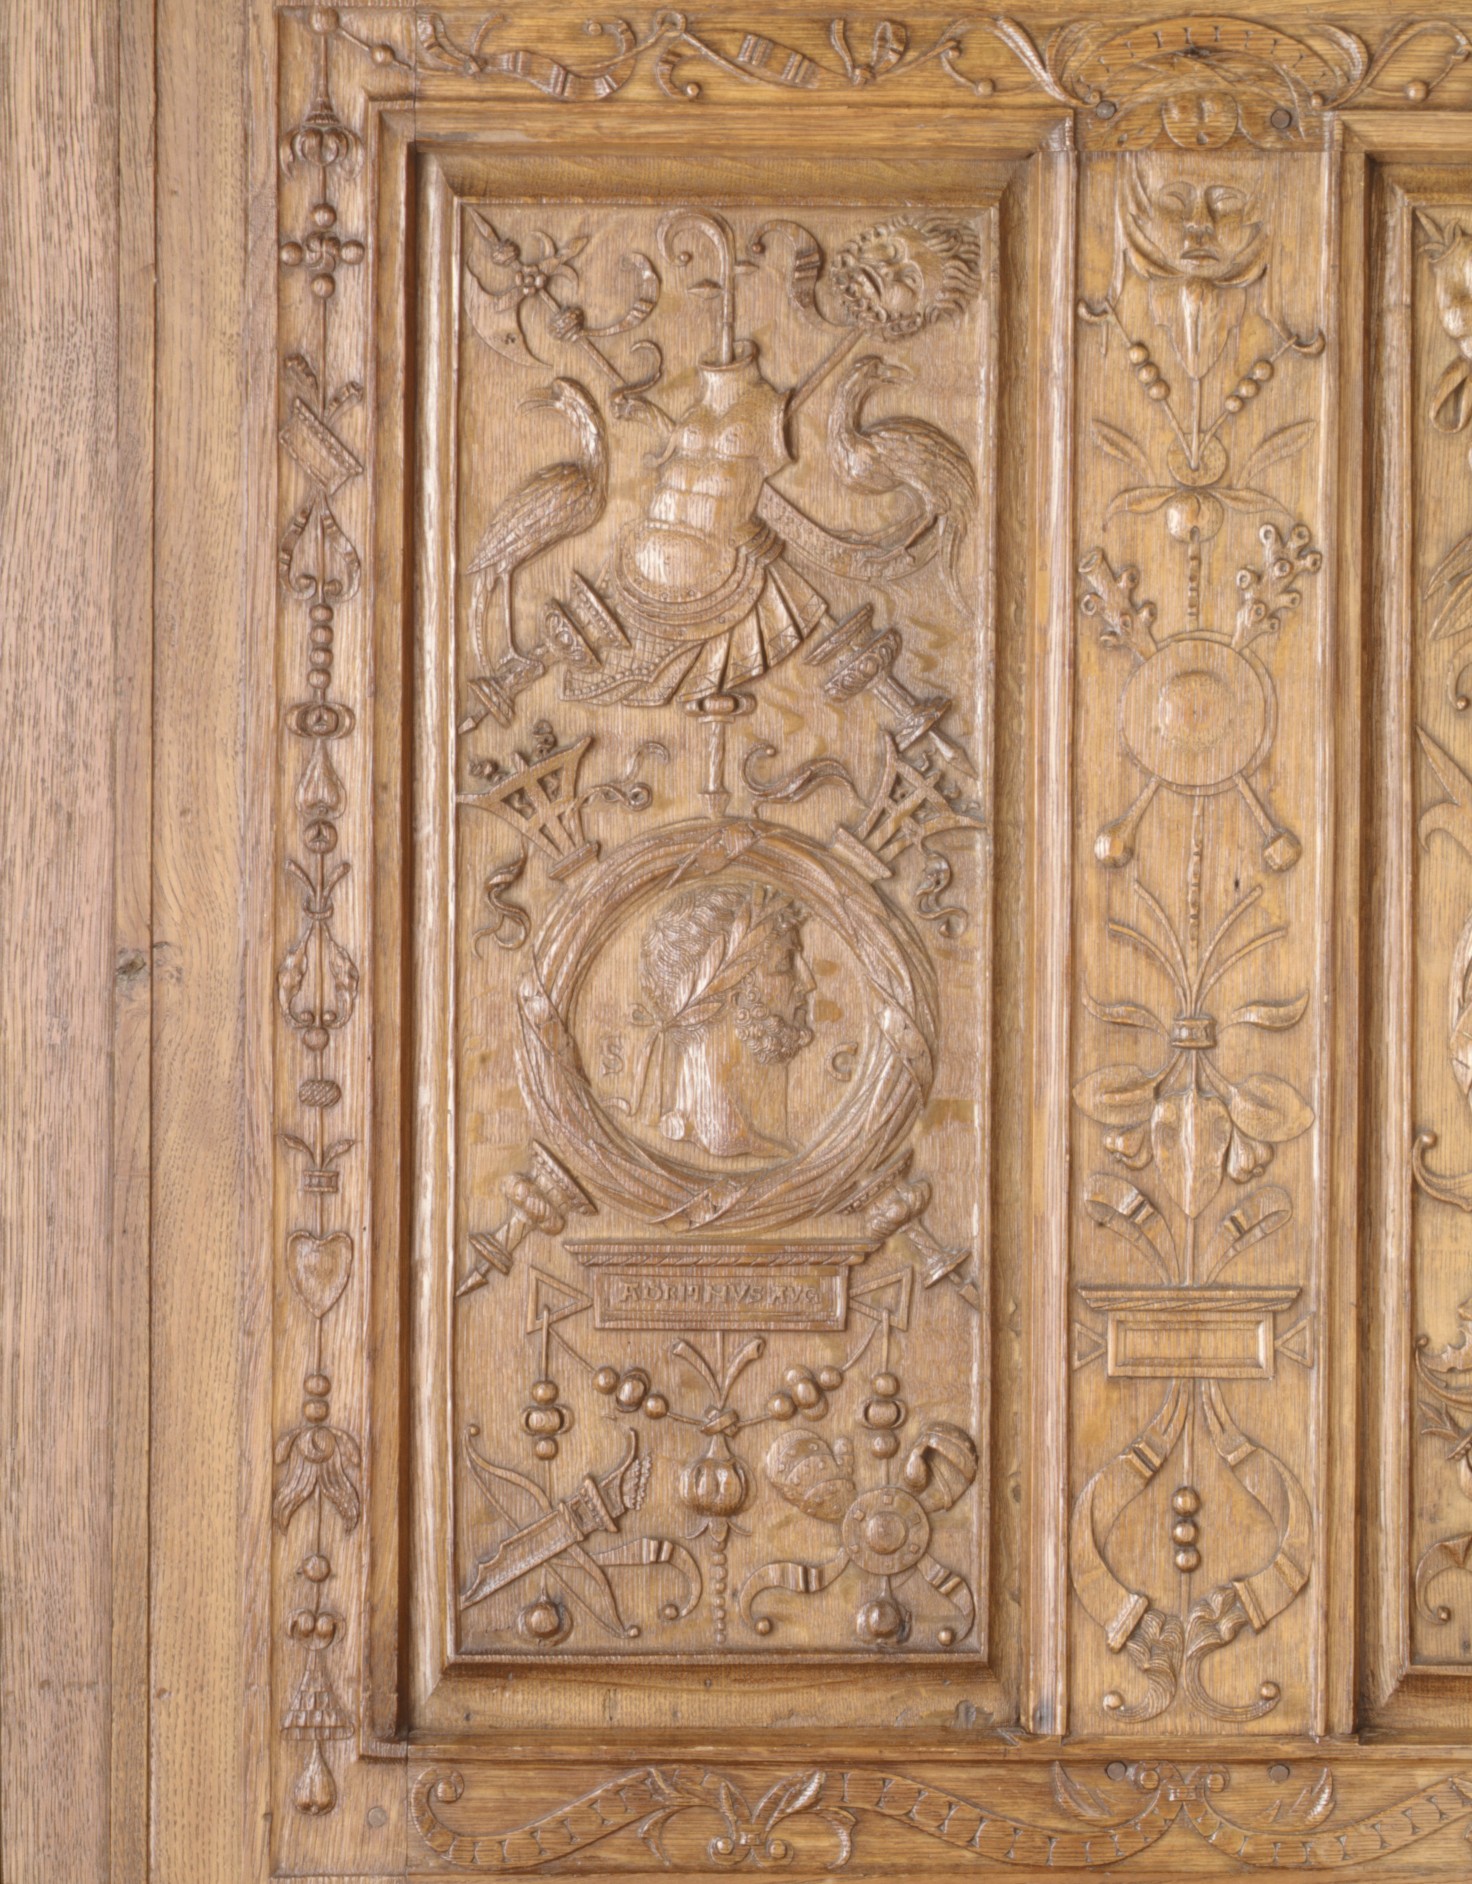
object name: panel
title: Panel (part of a set)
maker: nicolas castille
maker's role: maker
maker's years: 1503-1521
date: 1510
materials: wood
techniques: carving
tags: birds,bow and arrow,shields,heads